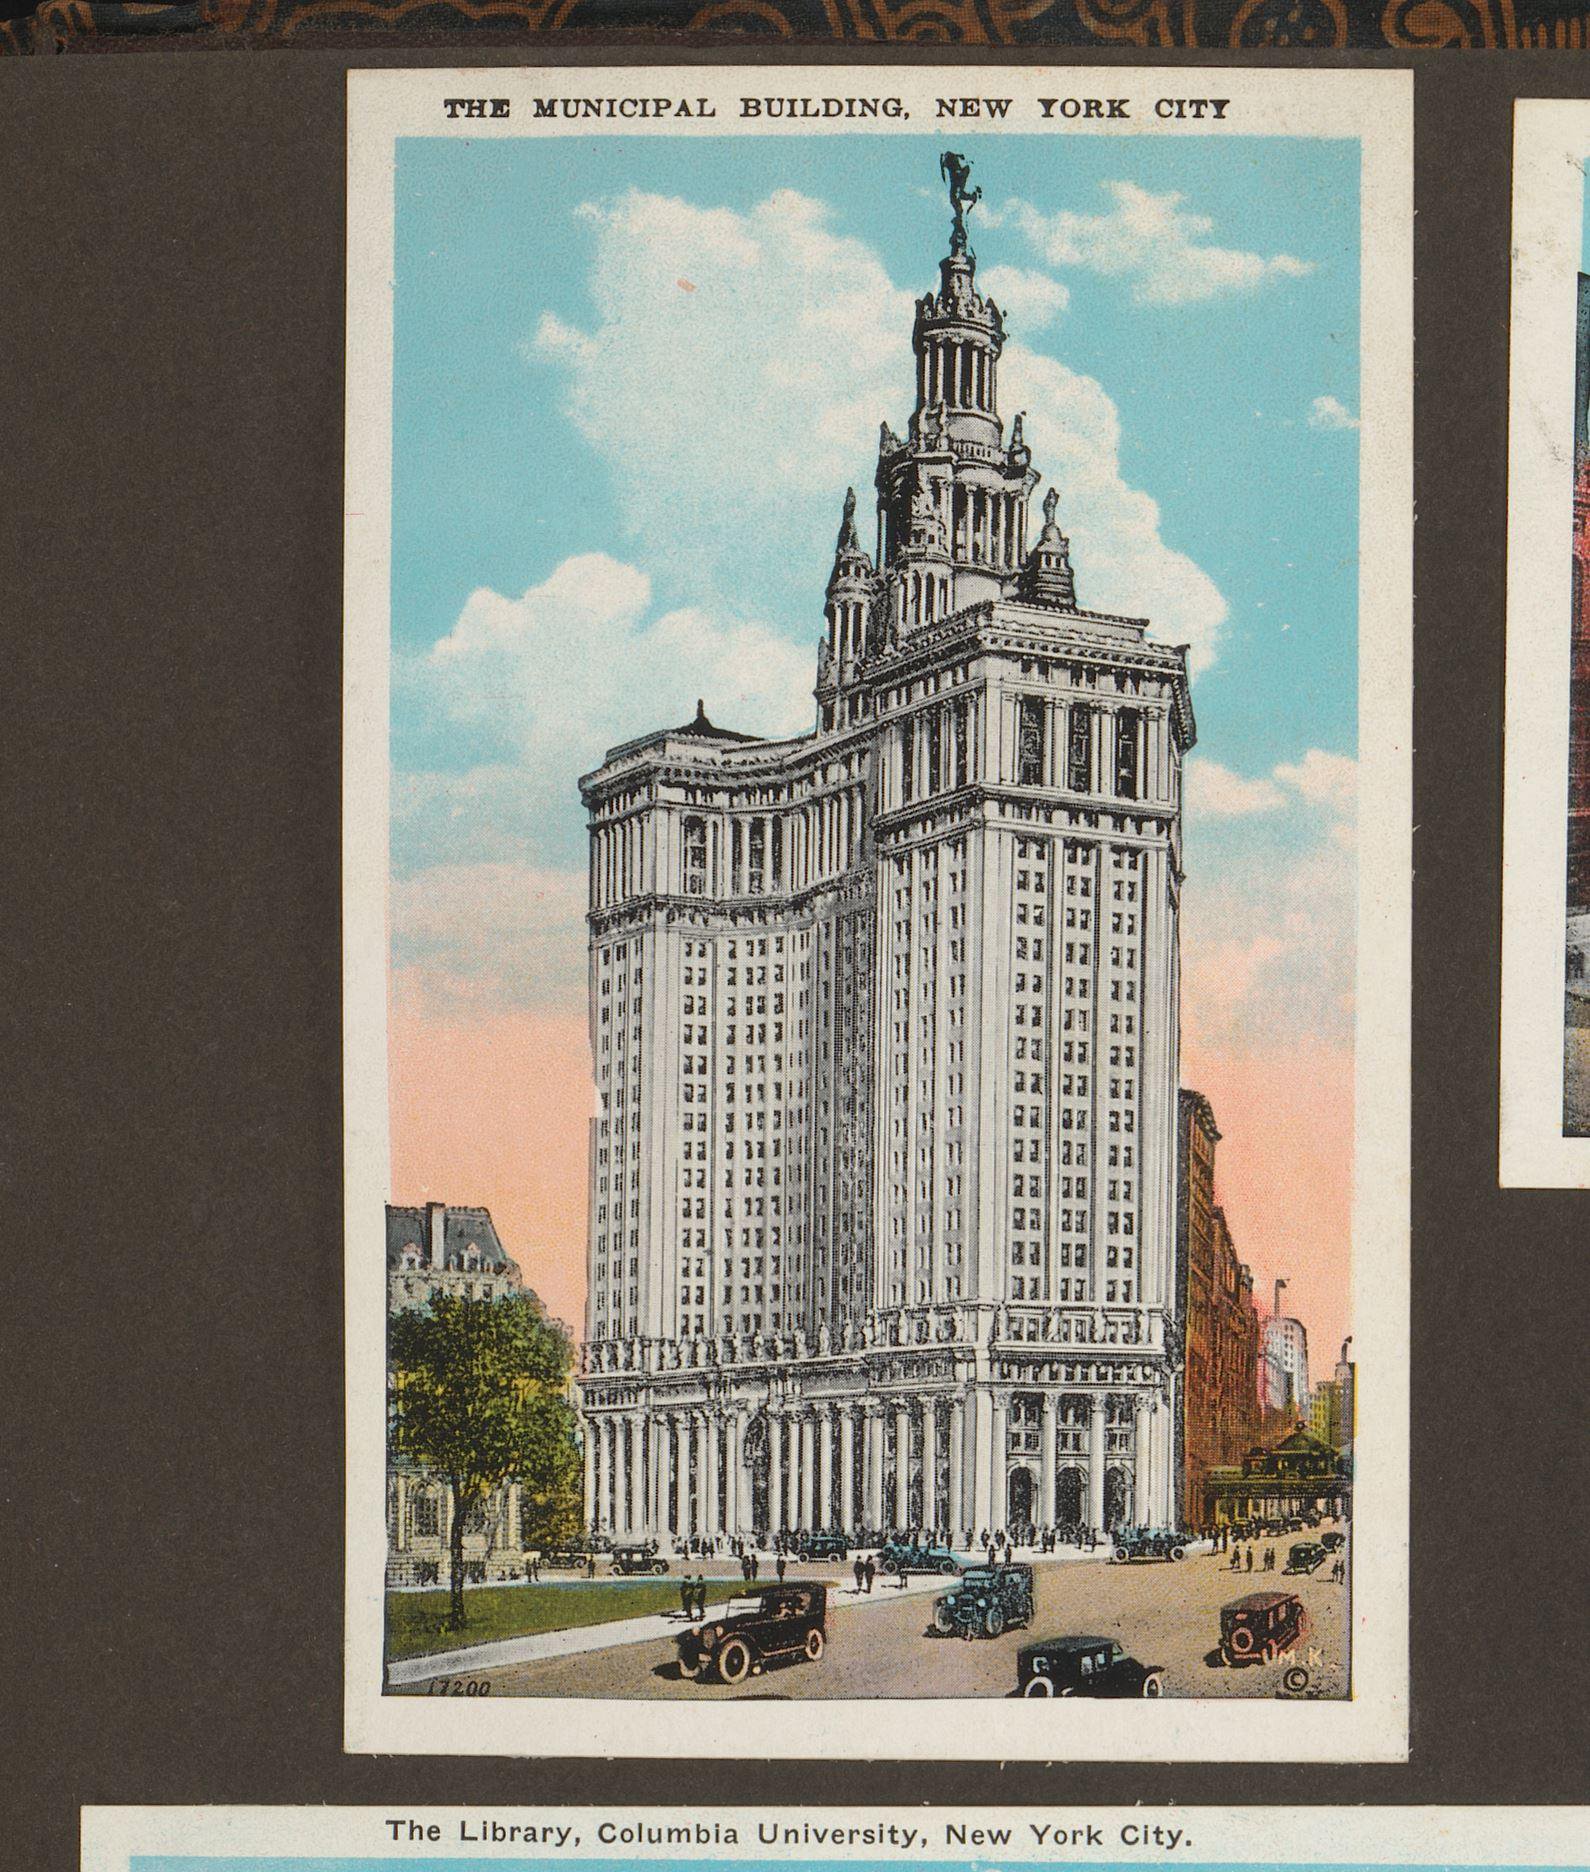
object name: ansichtkaart, prentbriefkaart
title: The municipal building, New York City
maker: Anonymous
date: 1928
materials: paper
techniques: four-color autotype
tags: skyscraper, new york (city)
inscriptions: inscription: ‘M. K.’, number: ‘17200’